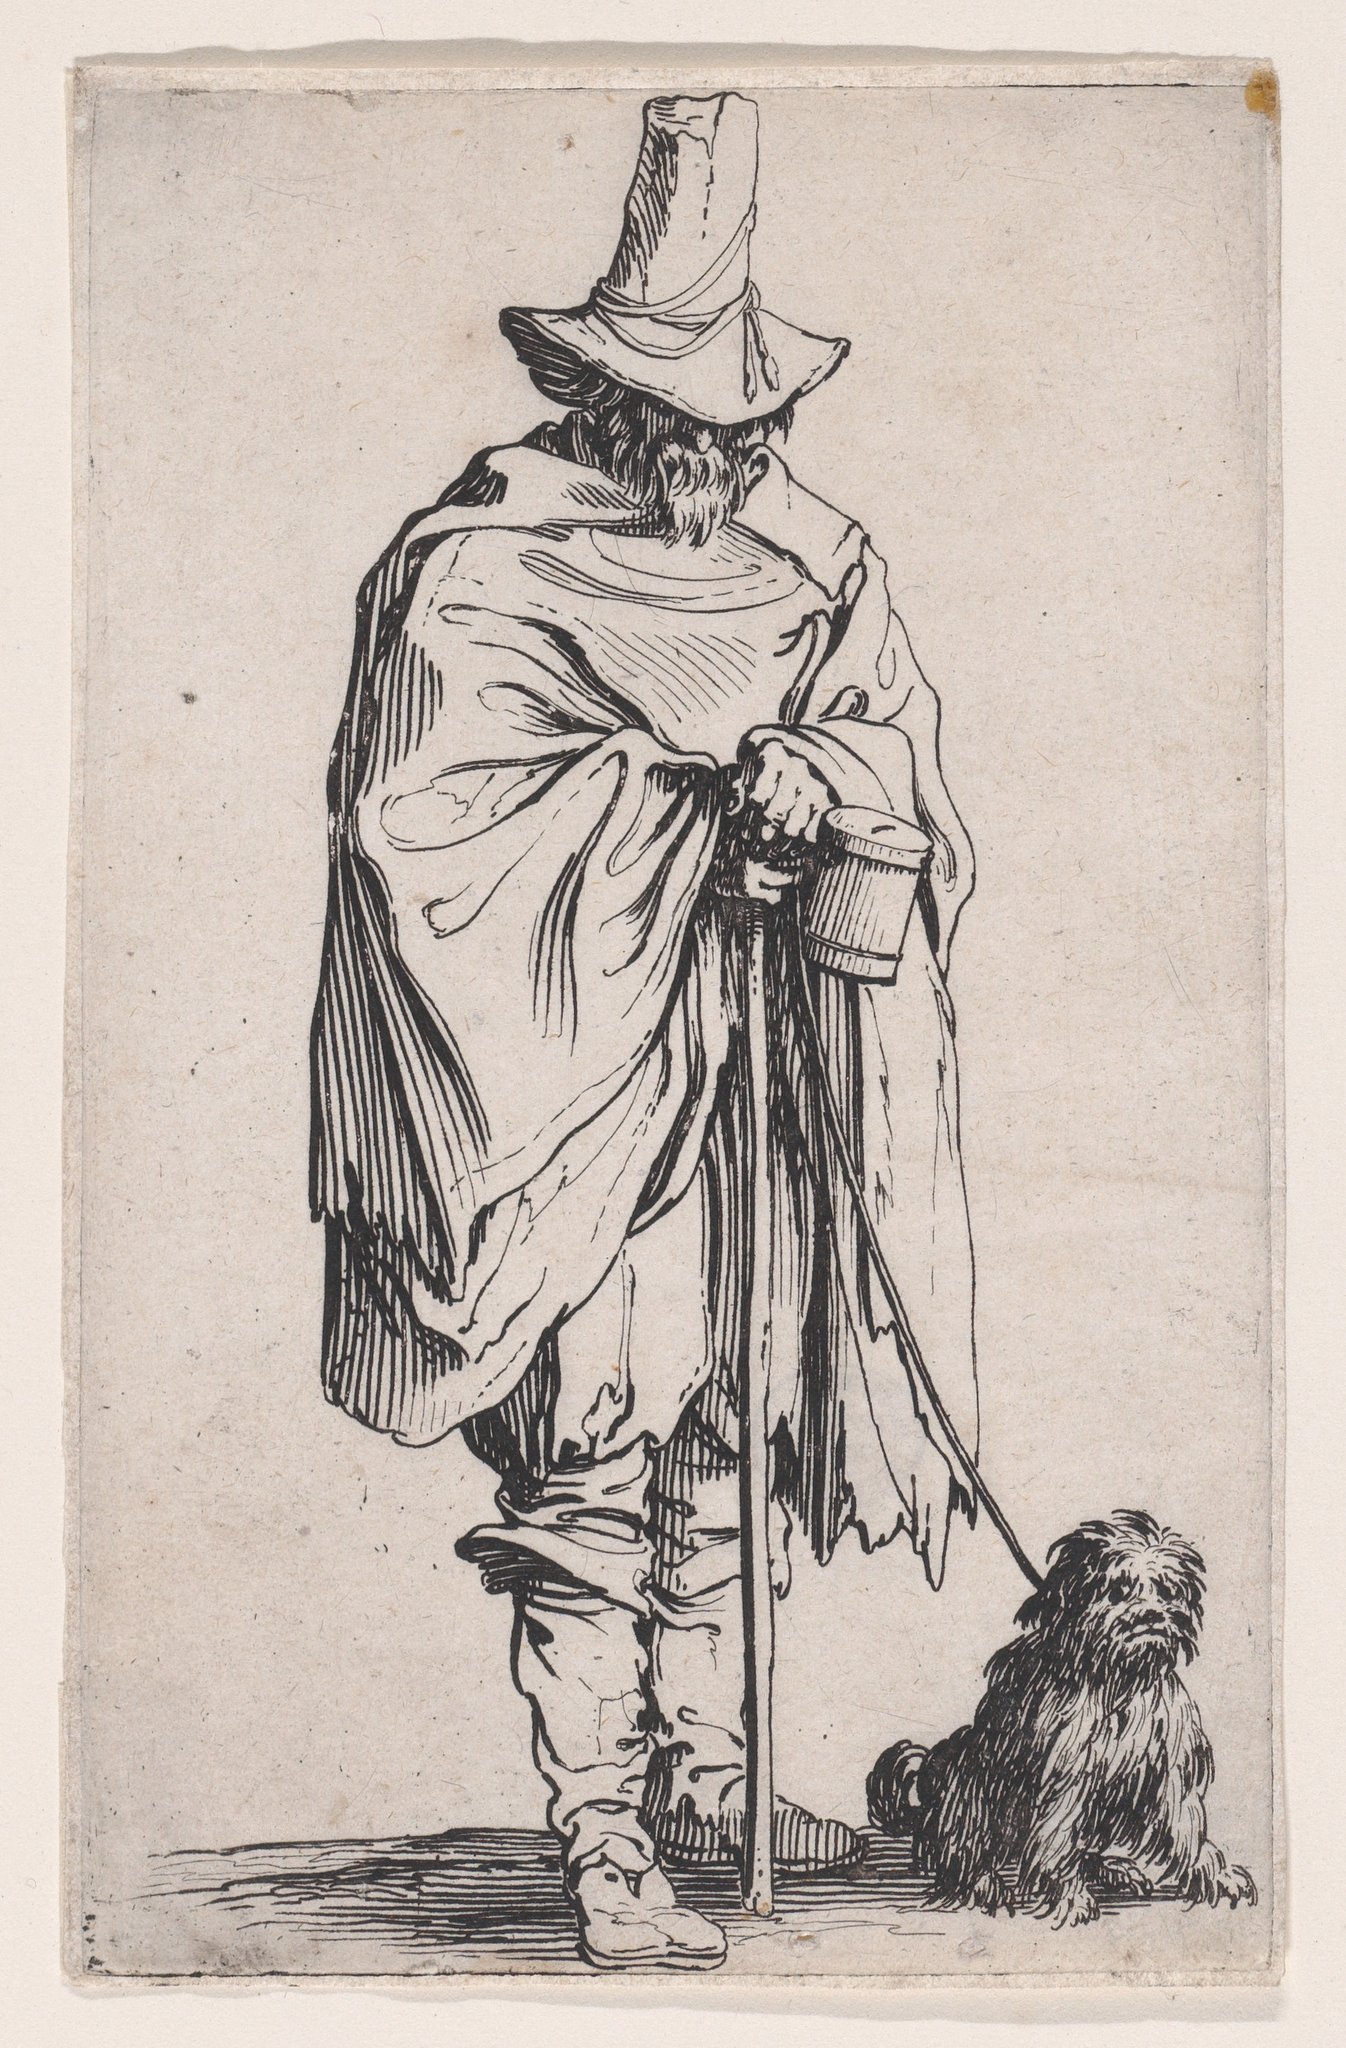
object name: print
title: L'Aveugle et son Chien (The Beggar and his Dog), from "Les Gueux suite appelée aussi Les Mendiants, Les Baroni, ou Les Barons" (The Beggars, also called the Barons)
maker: jacques callot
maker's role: artist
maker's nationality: french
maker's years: 1592-1635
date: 1623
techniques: etching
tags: men,dogs